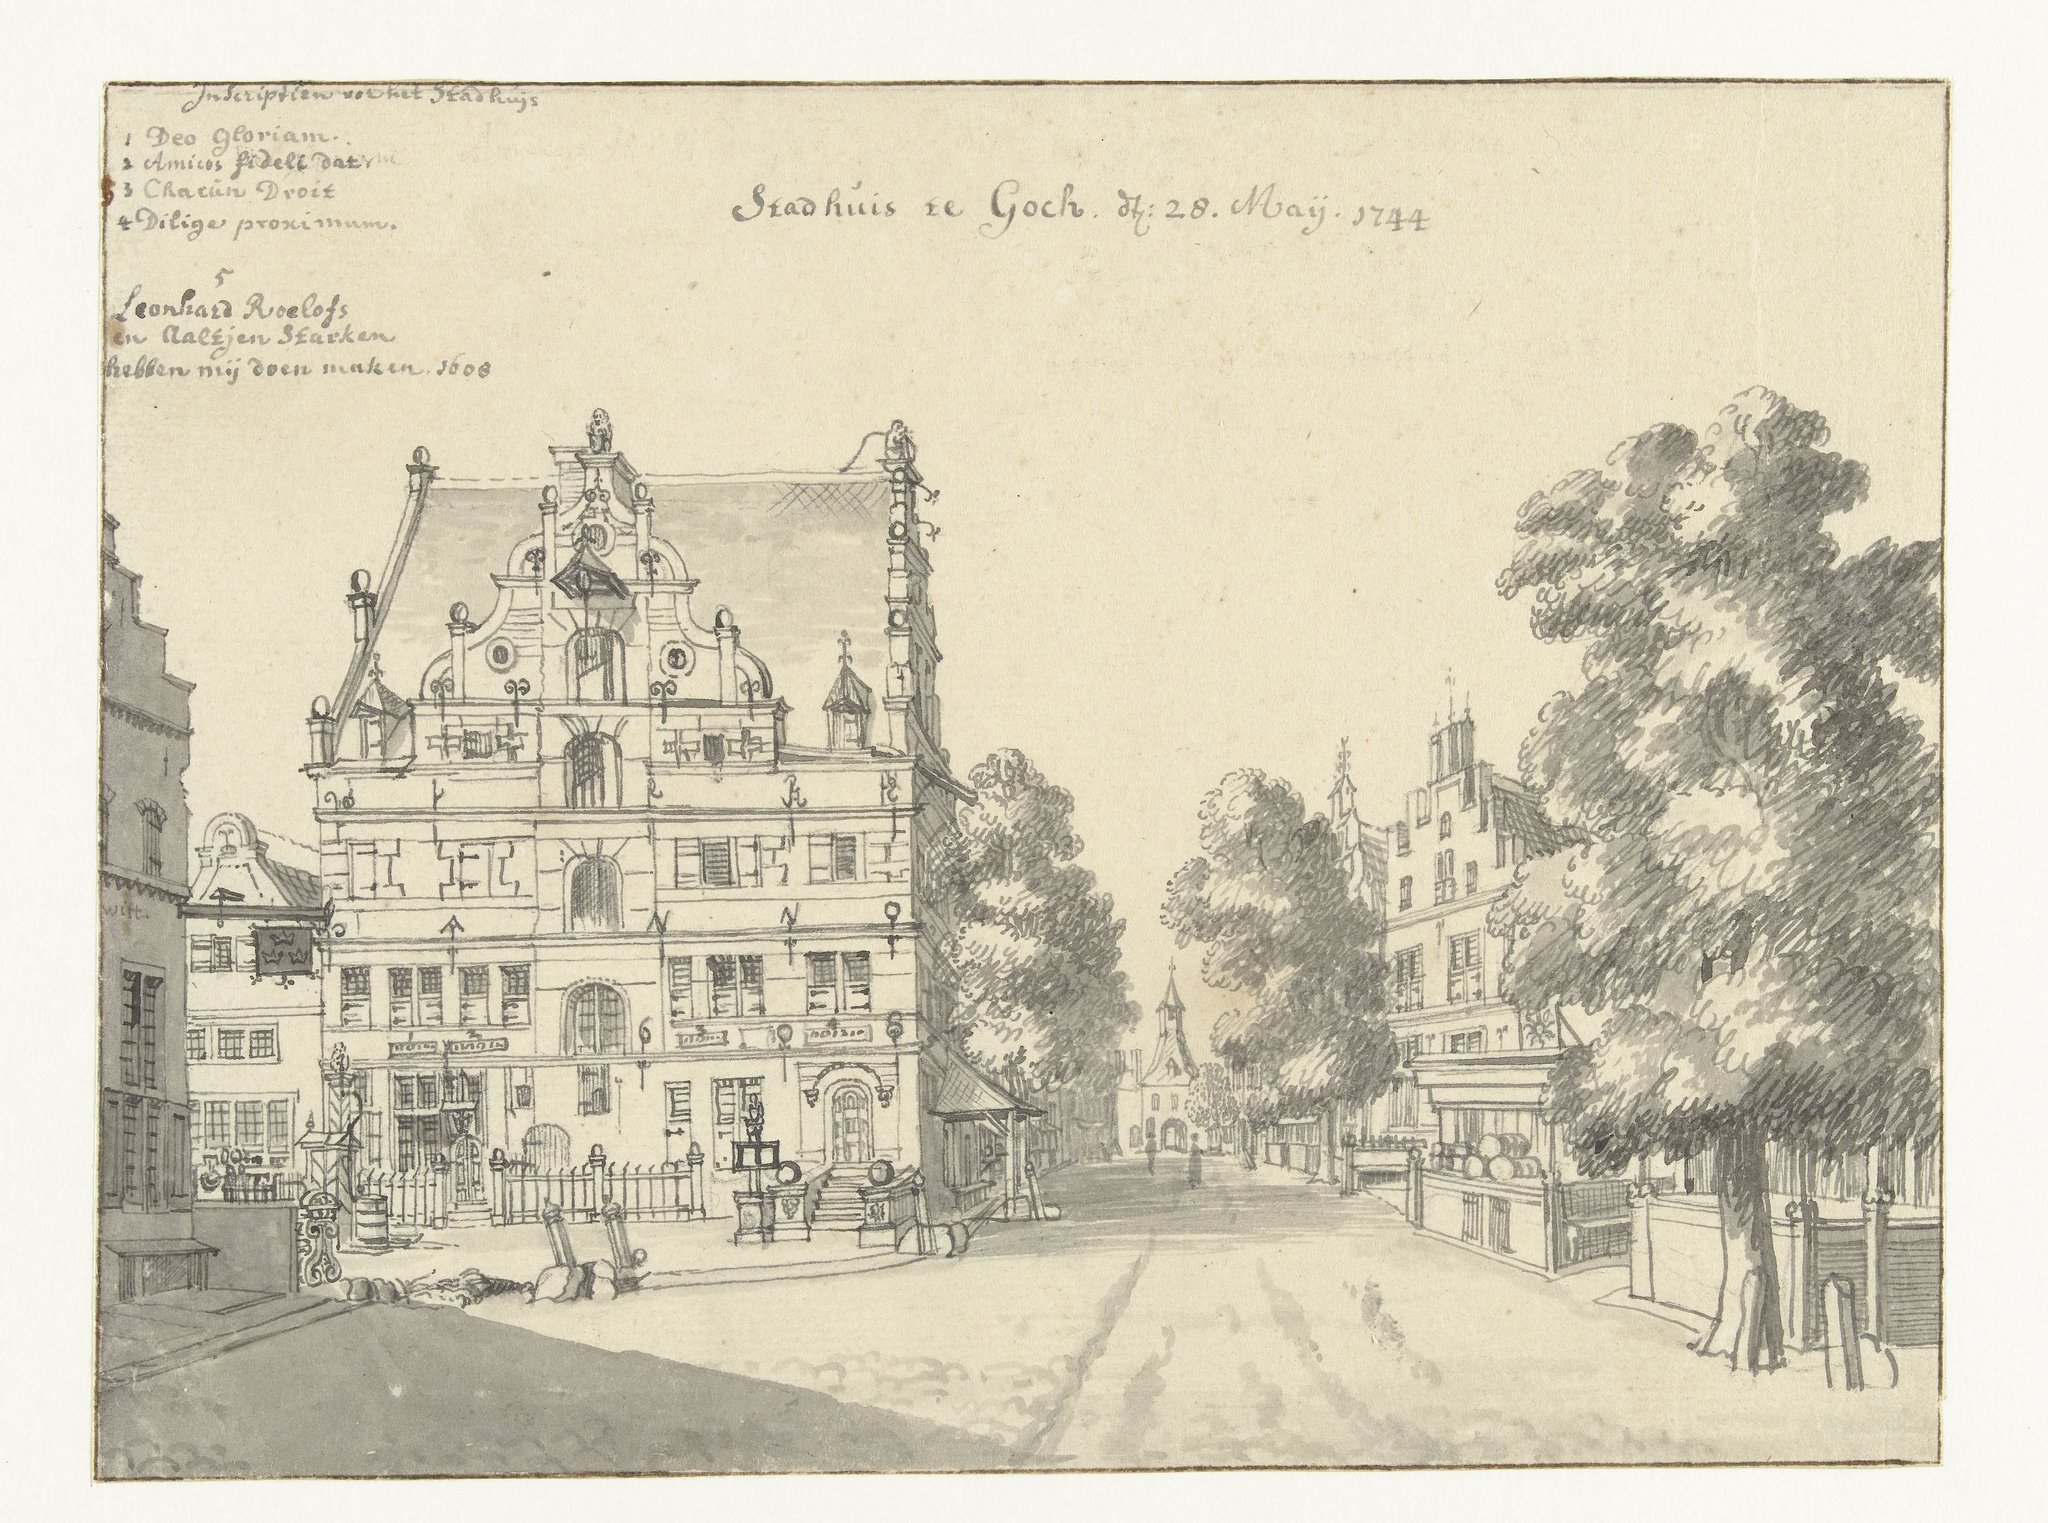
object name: drawing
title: Het stadhuis te Goch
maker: jan de beijer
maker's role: draughtsman, print maker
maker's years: 1703-1780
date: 1744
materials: ink, paper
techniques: brush, pen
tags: townhall, public road, germany